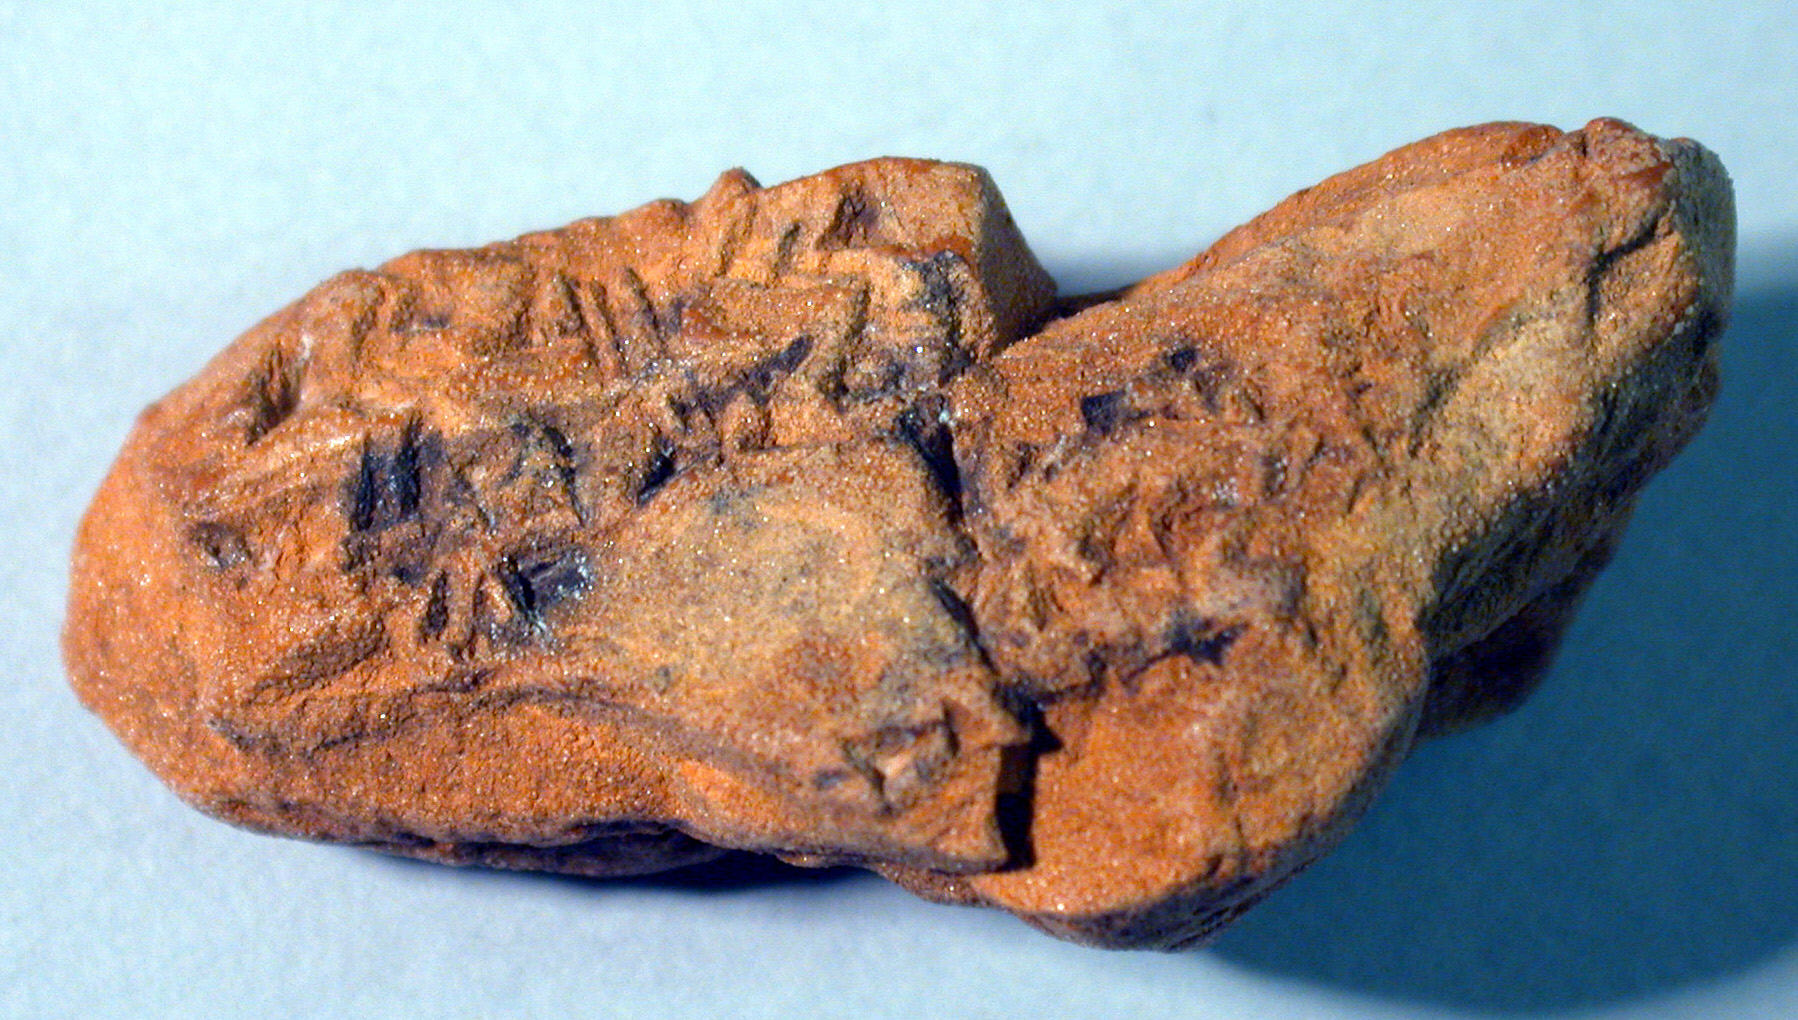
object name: cuneiform tablet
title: Cuneiform tablet: fragment, Ebabbar archive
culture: achaemenid or babylonian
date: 700-301 BCE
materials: clay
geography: mesopotamia